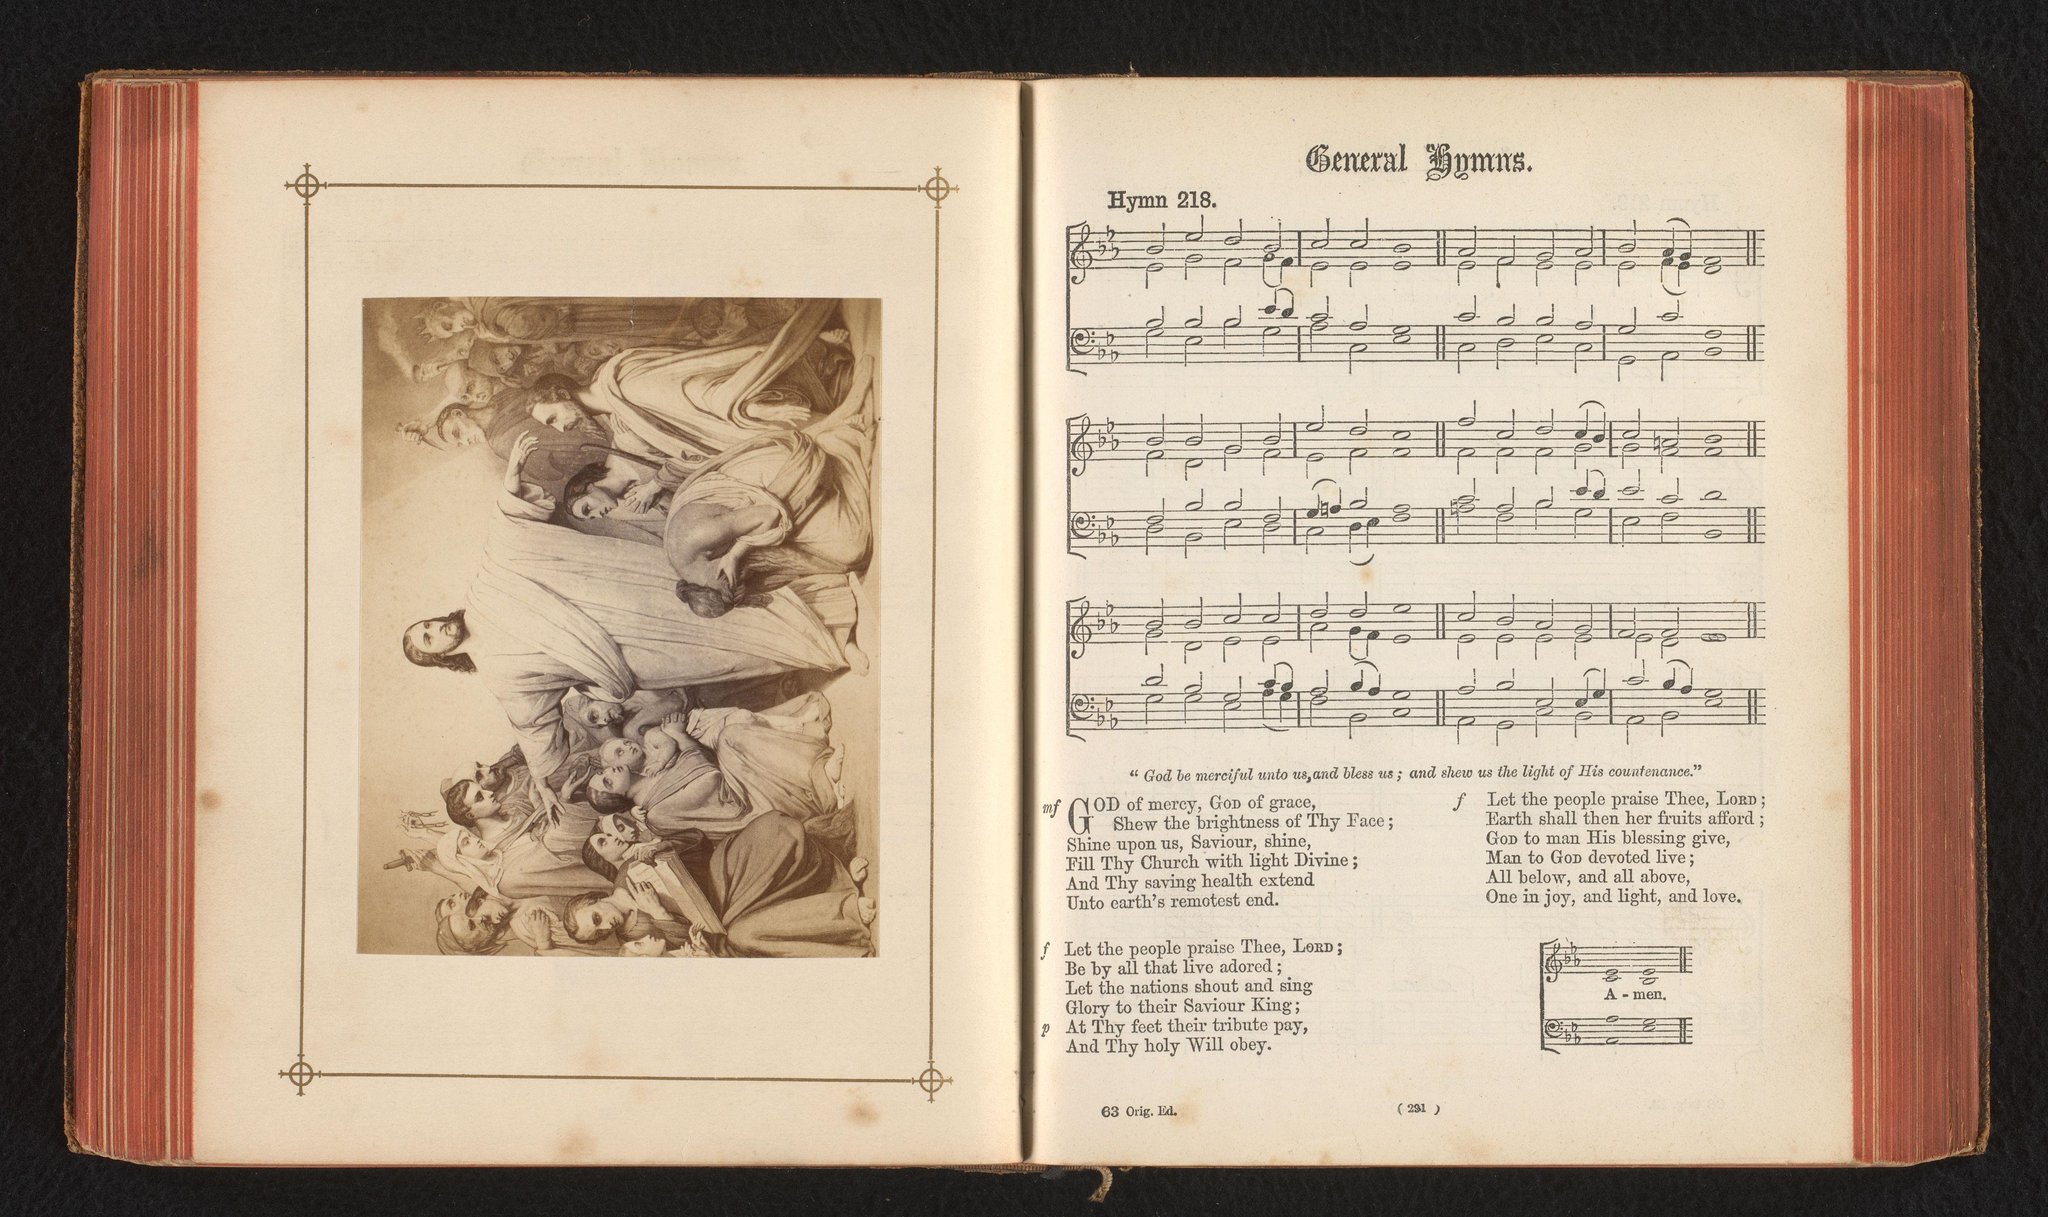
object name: reproduction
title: Fotoreproductie van een schilderij van Christus met volgelingen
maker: Anonymous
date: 1866-1876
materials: paper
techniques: albumen print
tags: christ explaining his doctrine, picture, painting